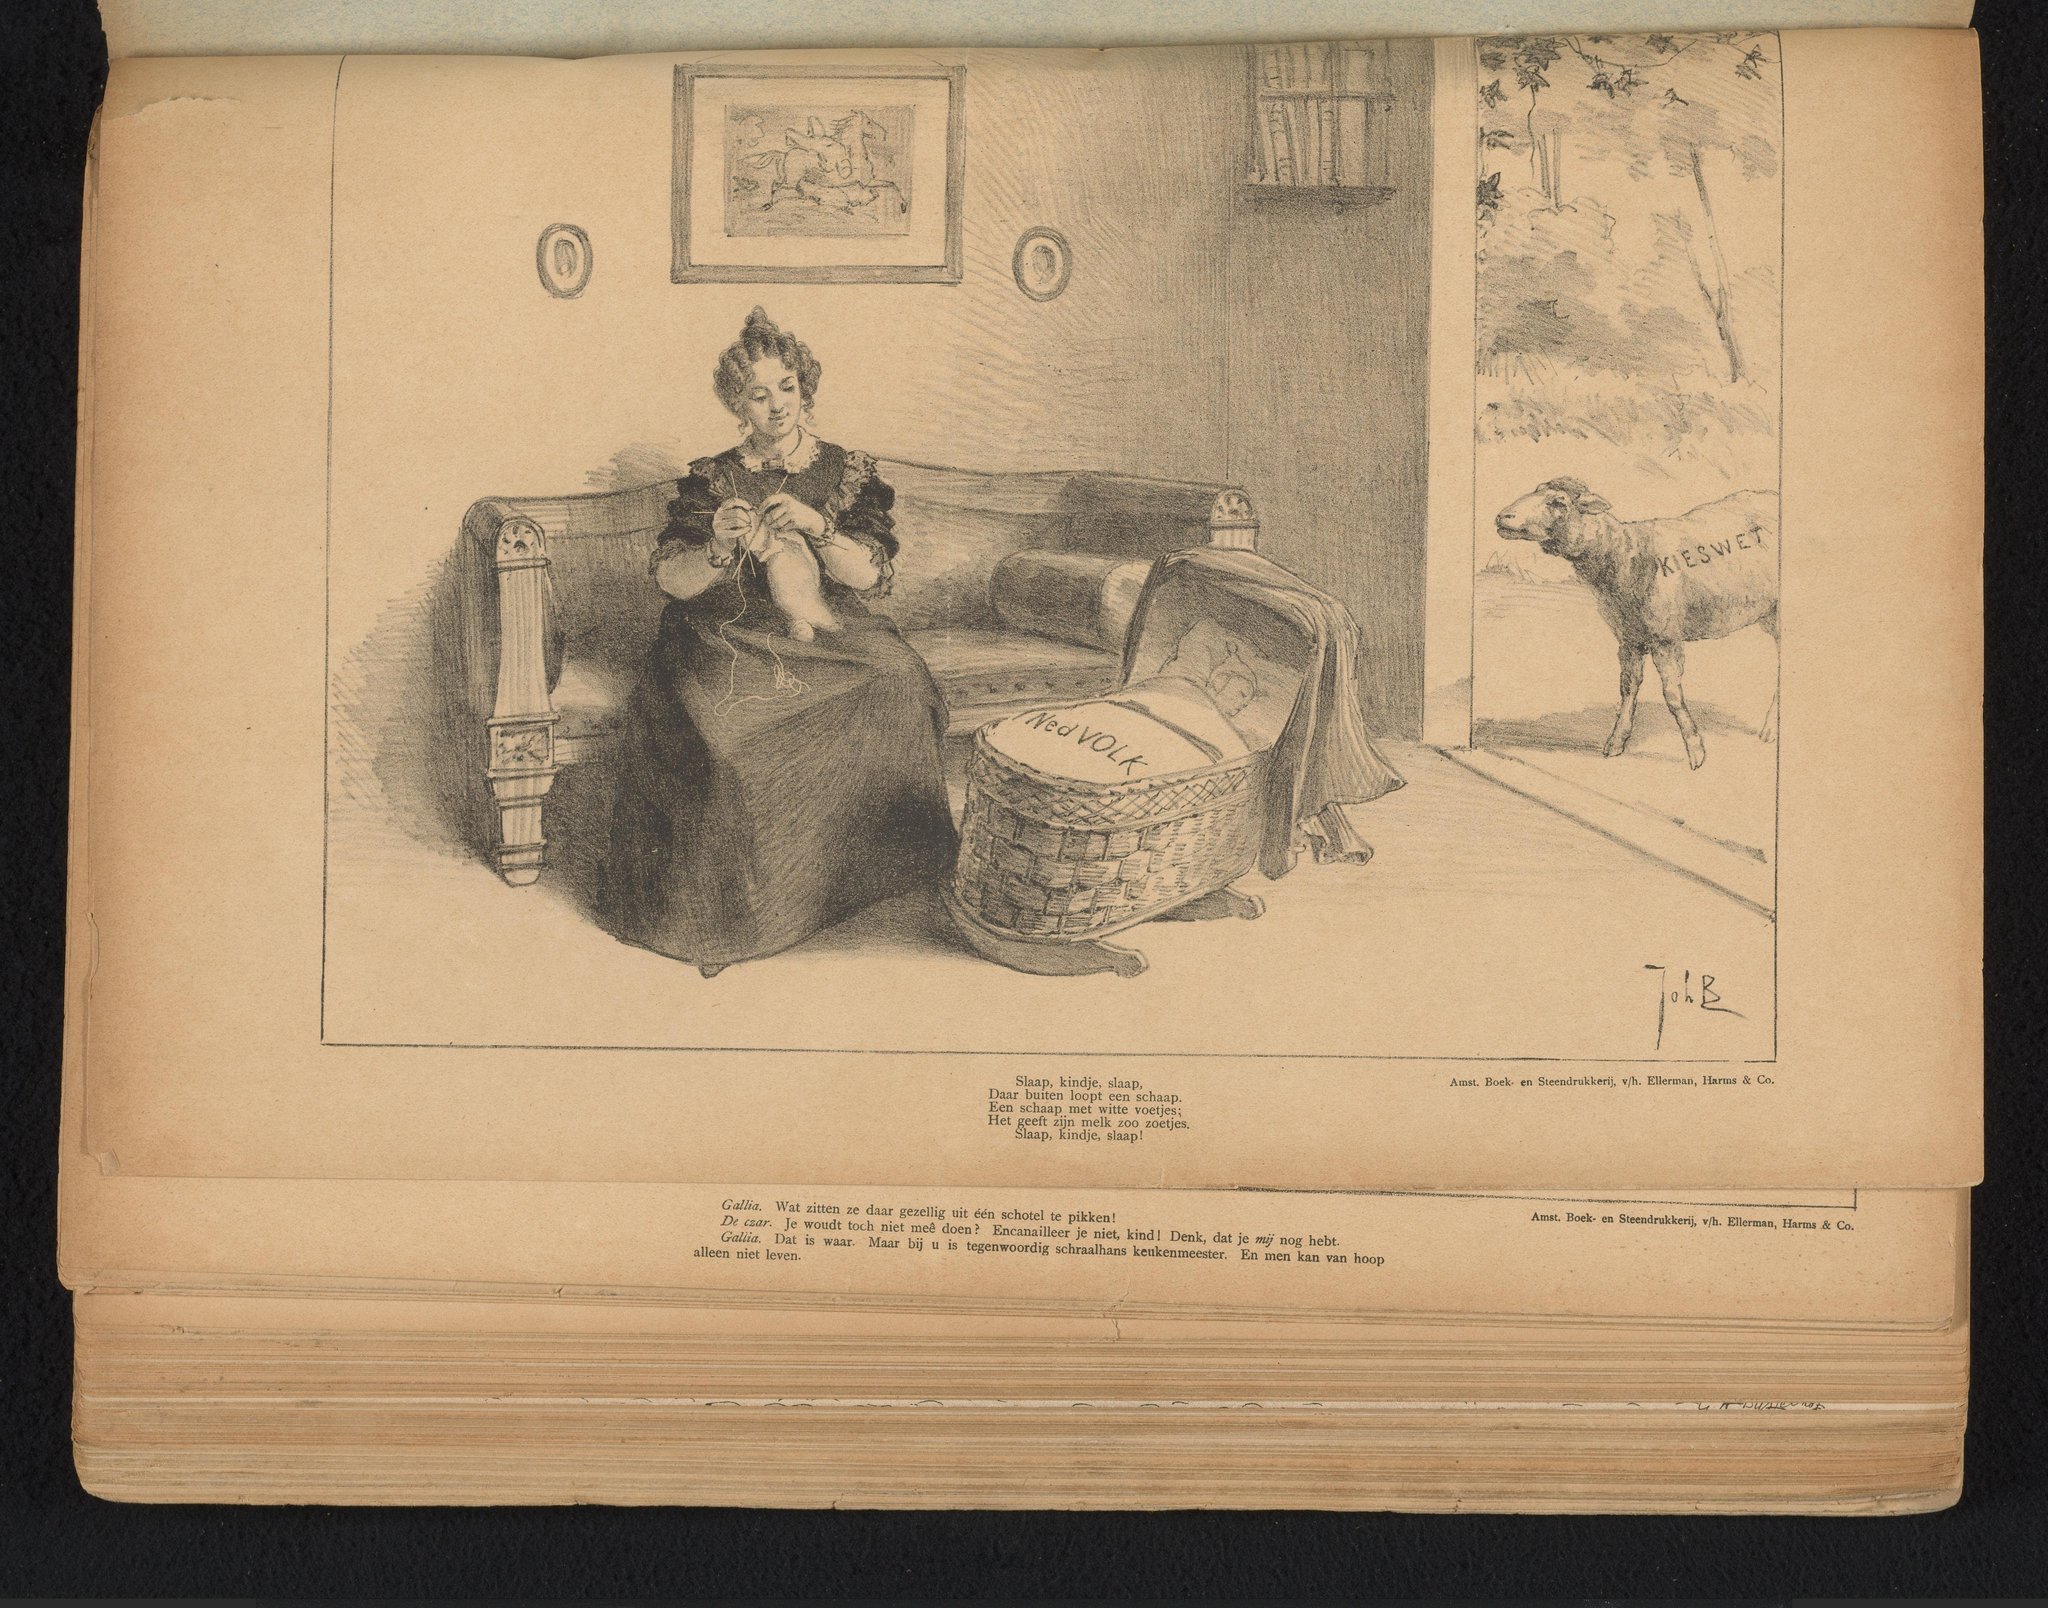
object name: cartoon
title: De regeerende klasse en het volk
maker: johan braakensiek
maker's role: draughtsman, print maker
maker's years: 1858-1940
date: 1891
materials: paper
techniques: lithograph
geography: amsterdam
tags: the right to vote, the compulsory vote, sheep, cradle, crib, mother and baby or young child, knitting, singing lullabies, political caricatures and satires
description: Een breiende moeder, de regerende klasse, zingt een slaapliedje voor haar in een wieg slapende kind, het Nederlandse volk. Buiten loopt het schaap 'Kieswet'.